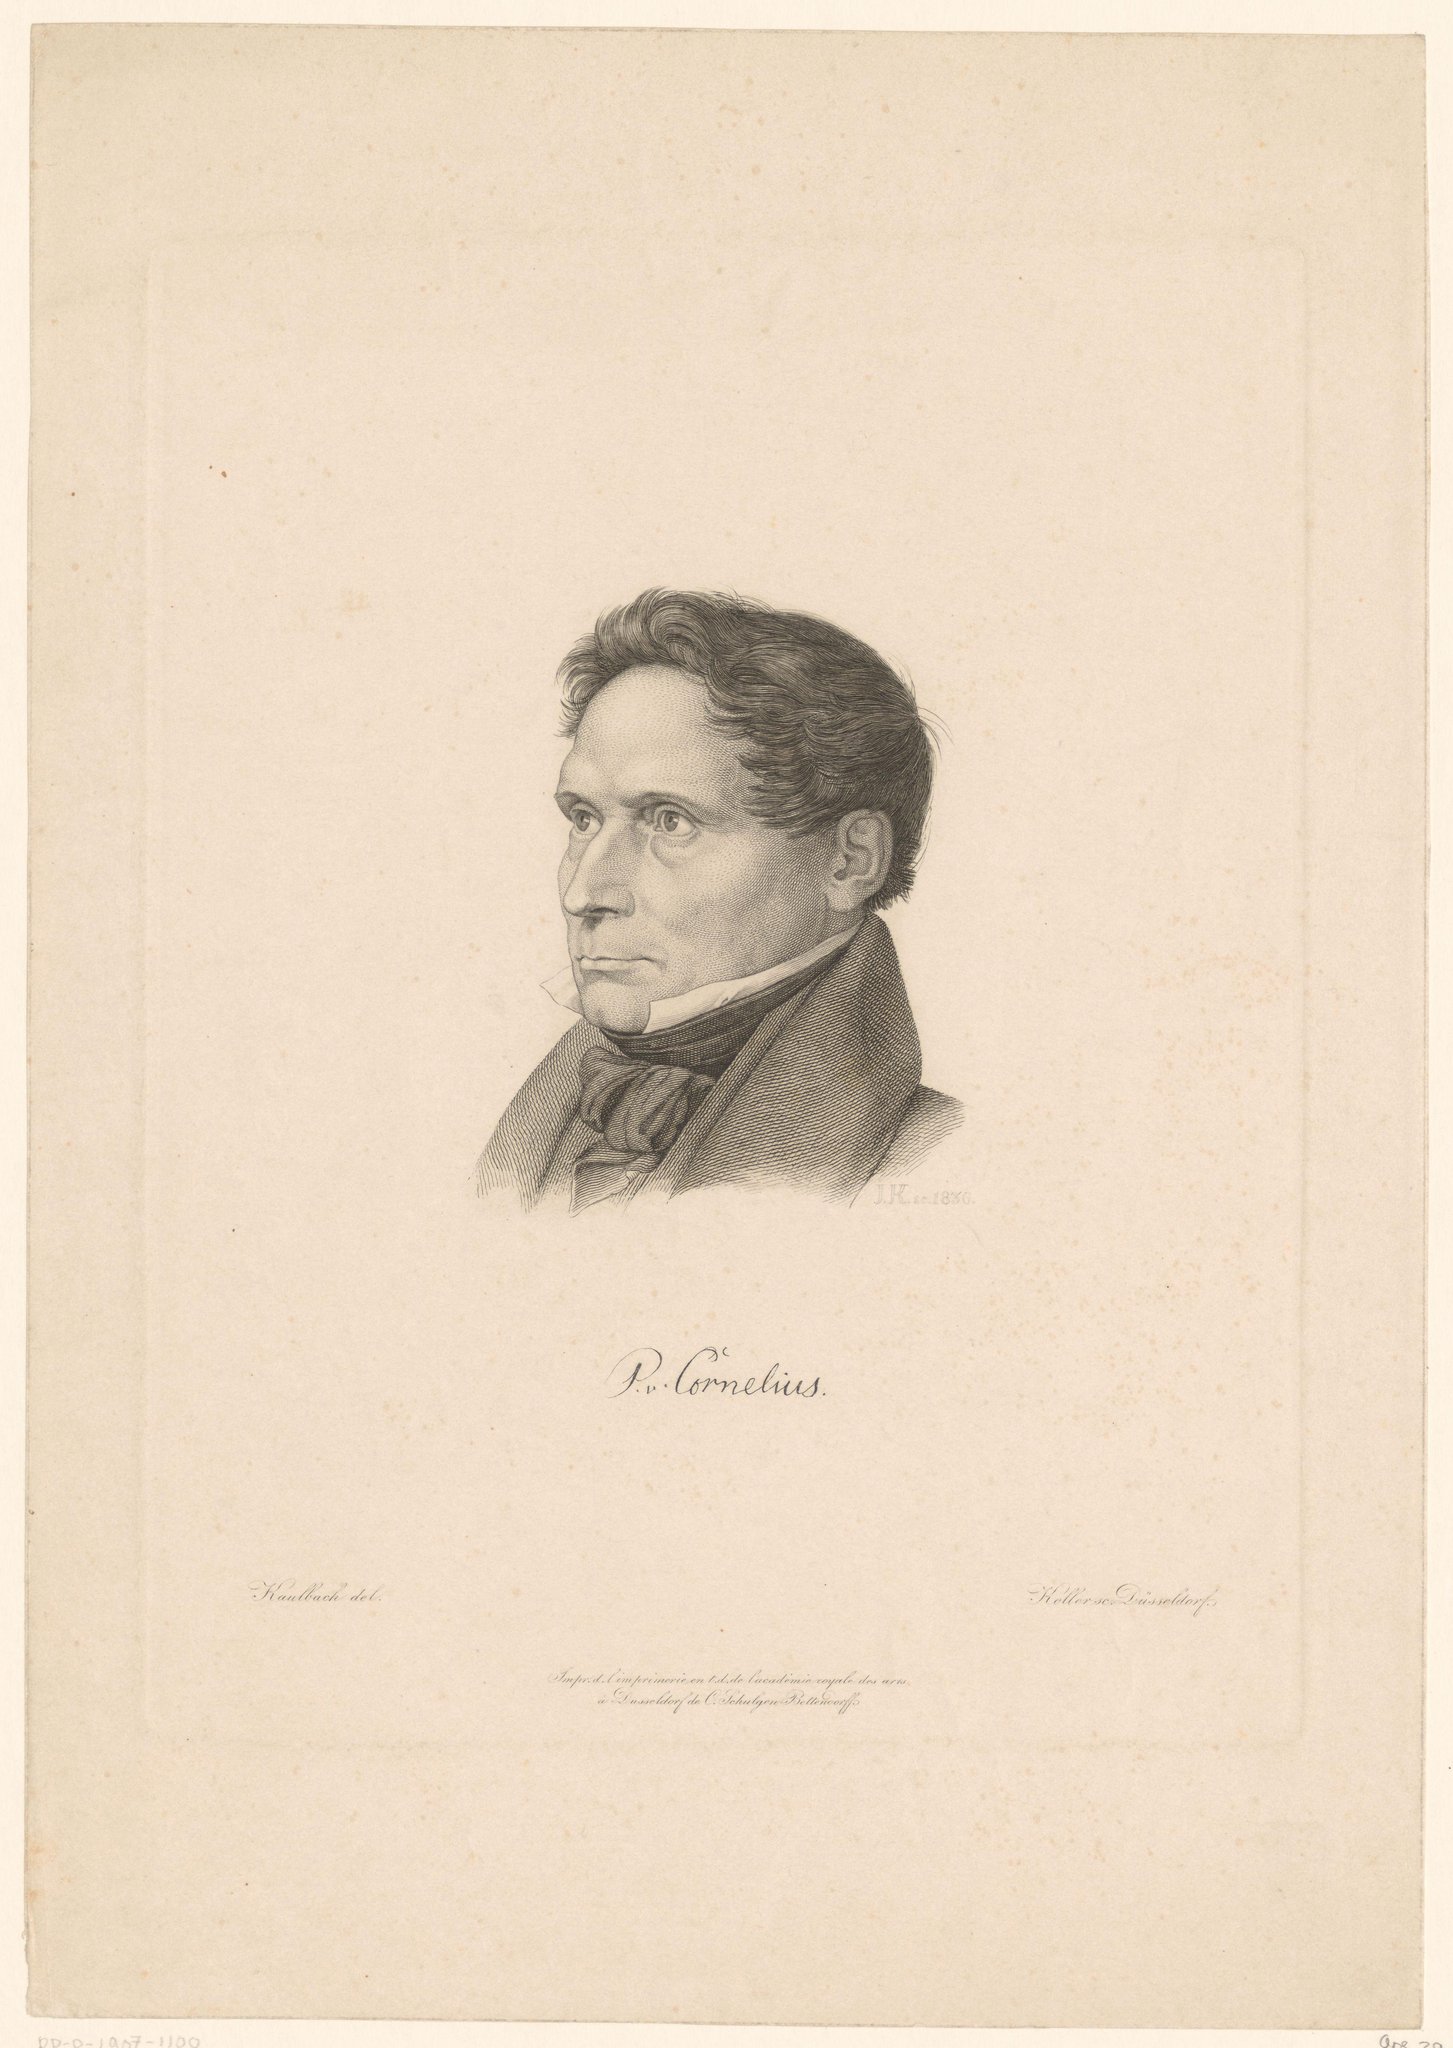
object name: print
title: Portret van Peter von Cornelius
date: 1836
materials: paper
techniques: engraving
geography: dusseldorf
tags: berlin, peter von cornelius, historical persons, portrait, self-portrait of painter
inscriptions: collector's mark: Lugt 2228